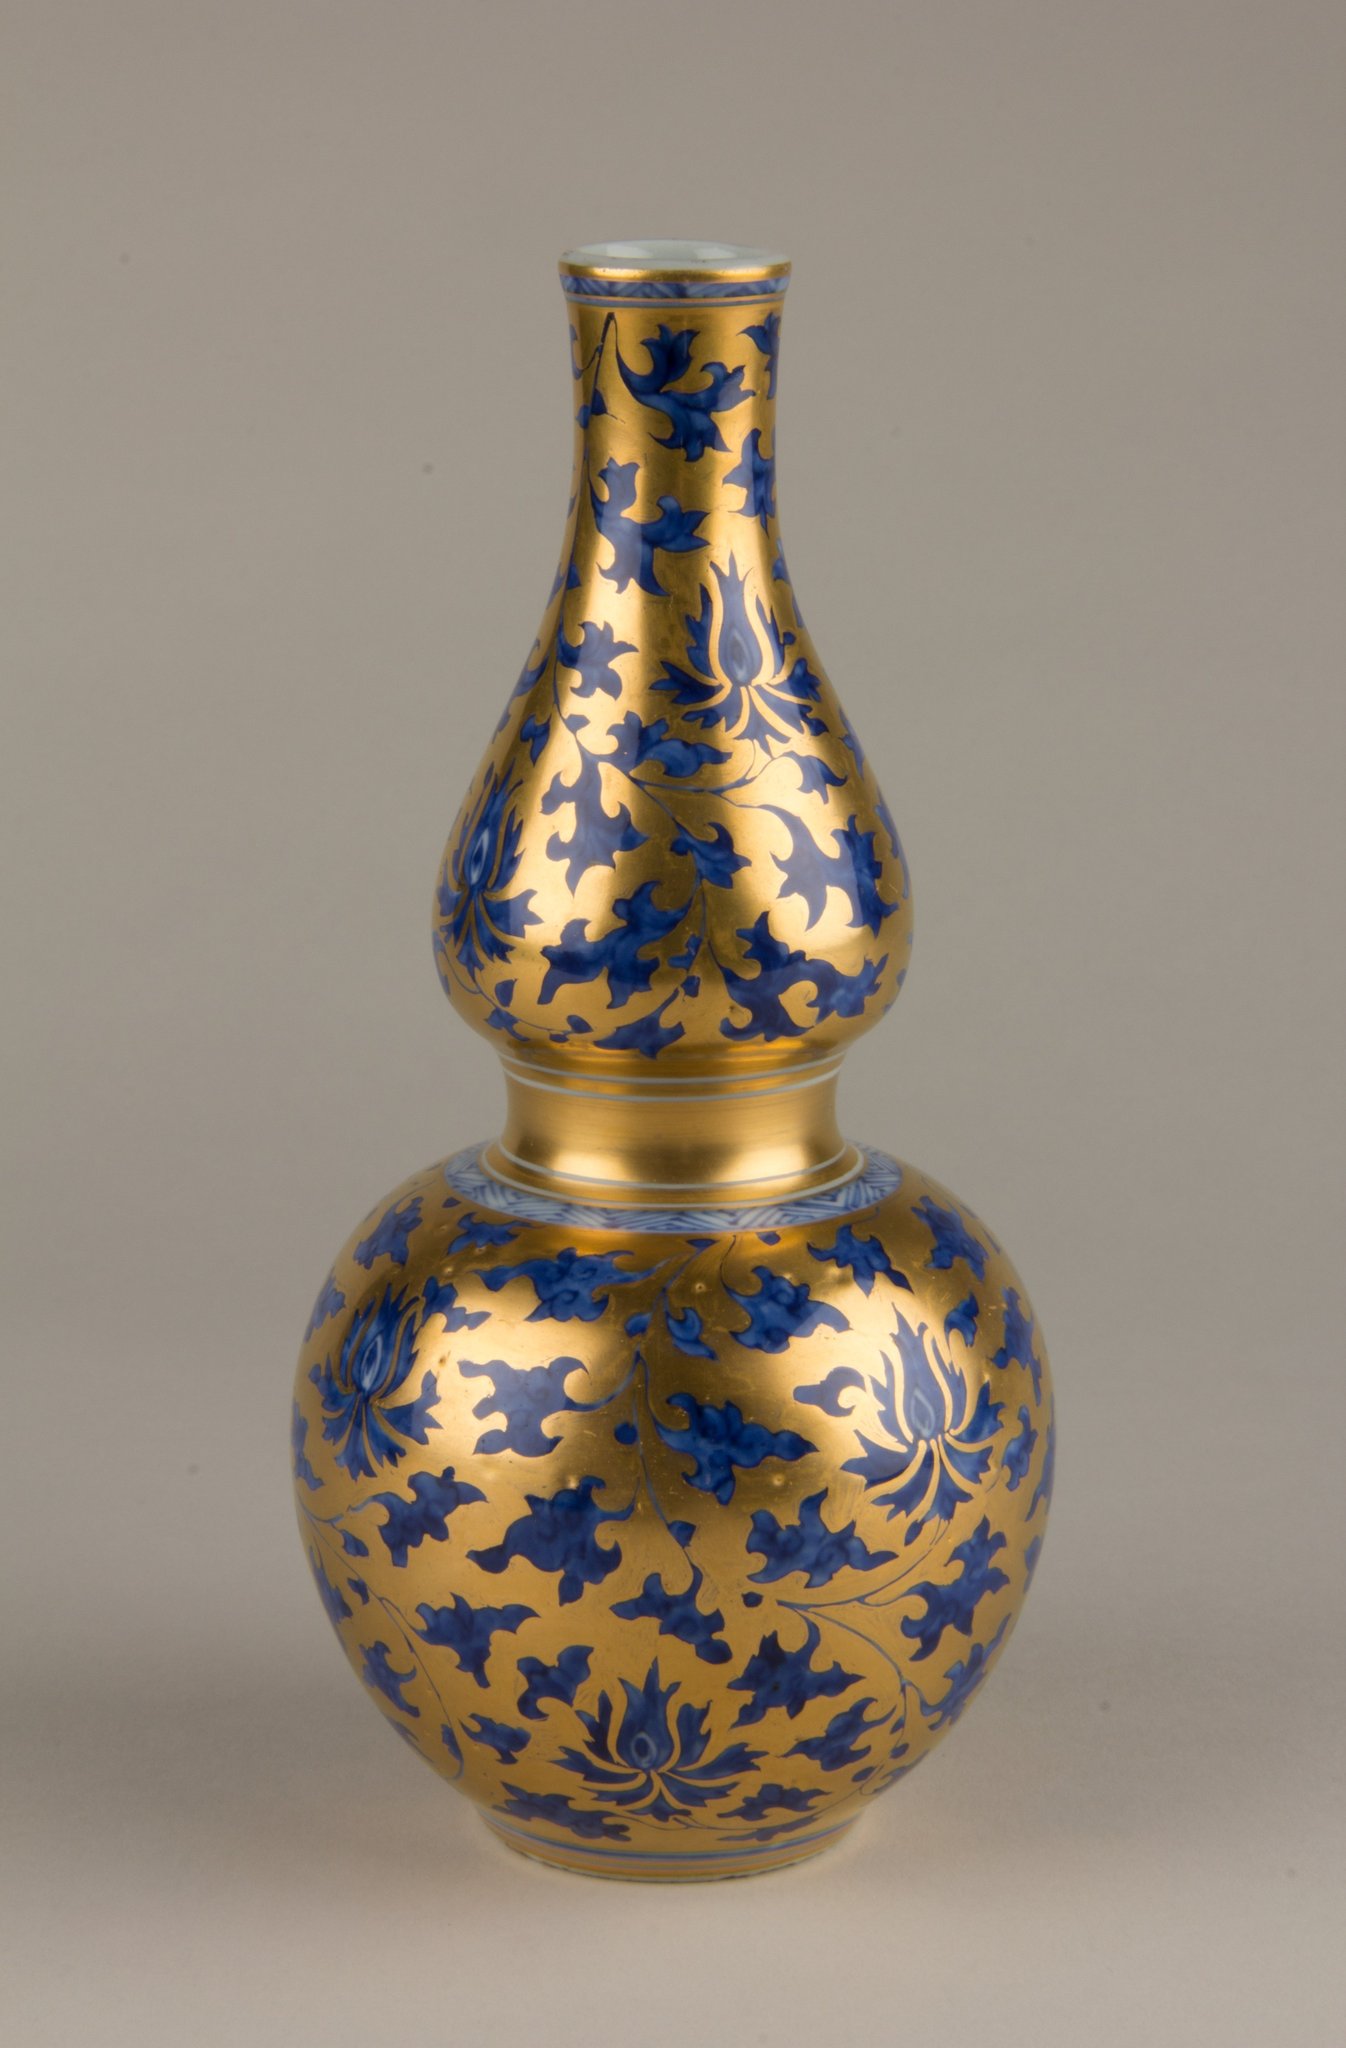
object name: vase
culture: chinese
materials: gilt, porcelain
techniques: overglaze, painting, underglaze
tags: flowers,leaves